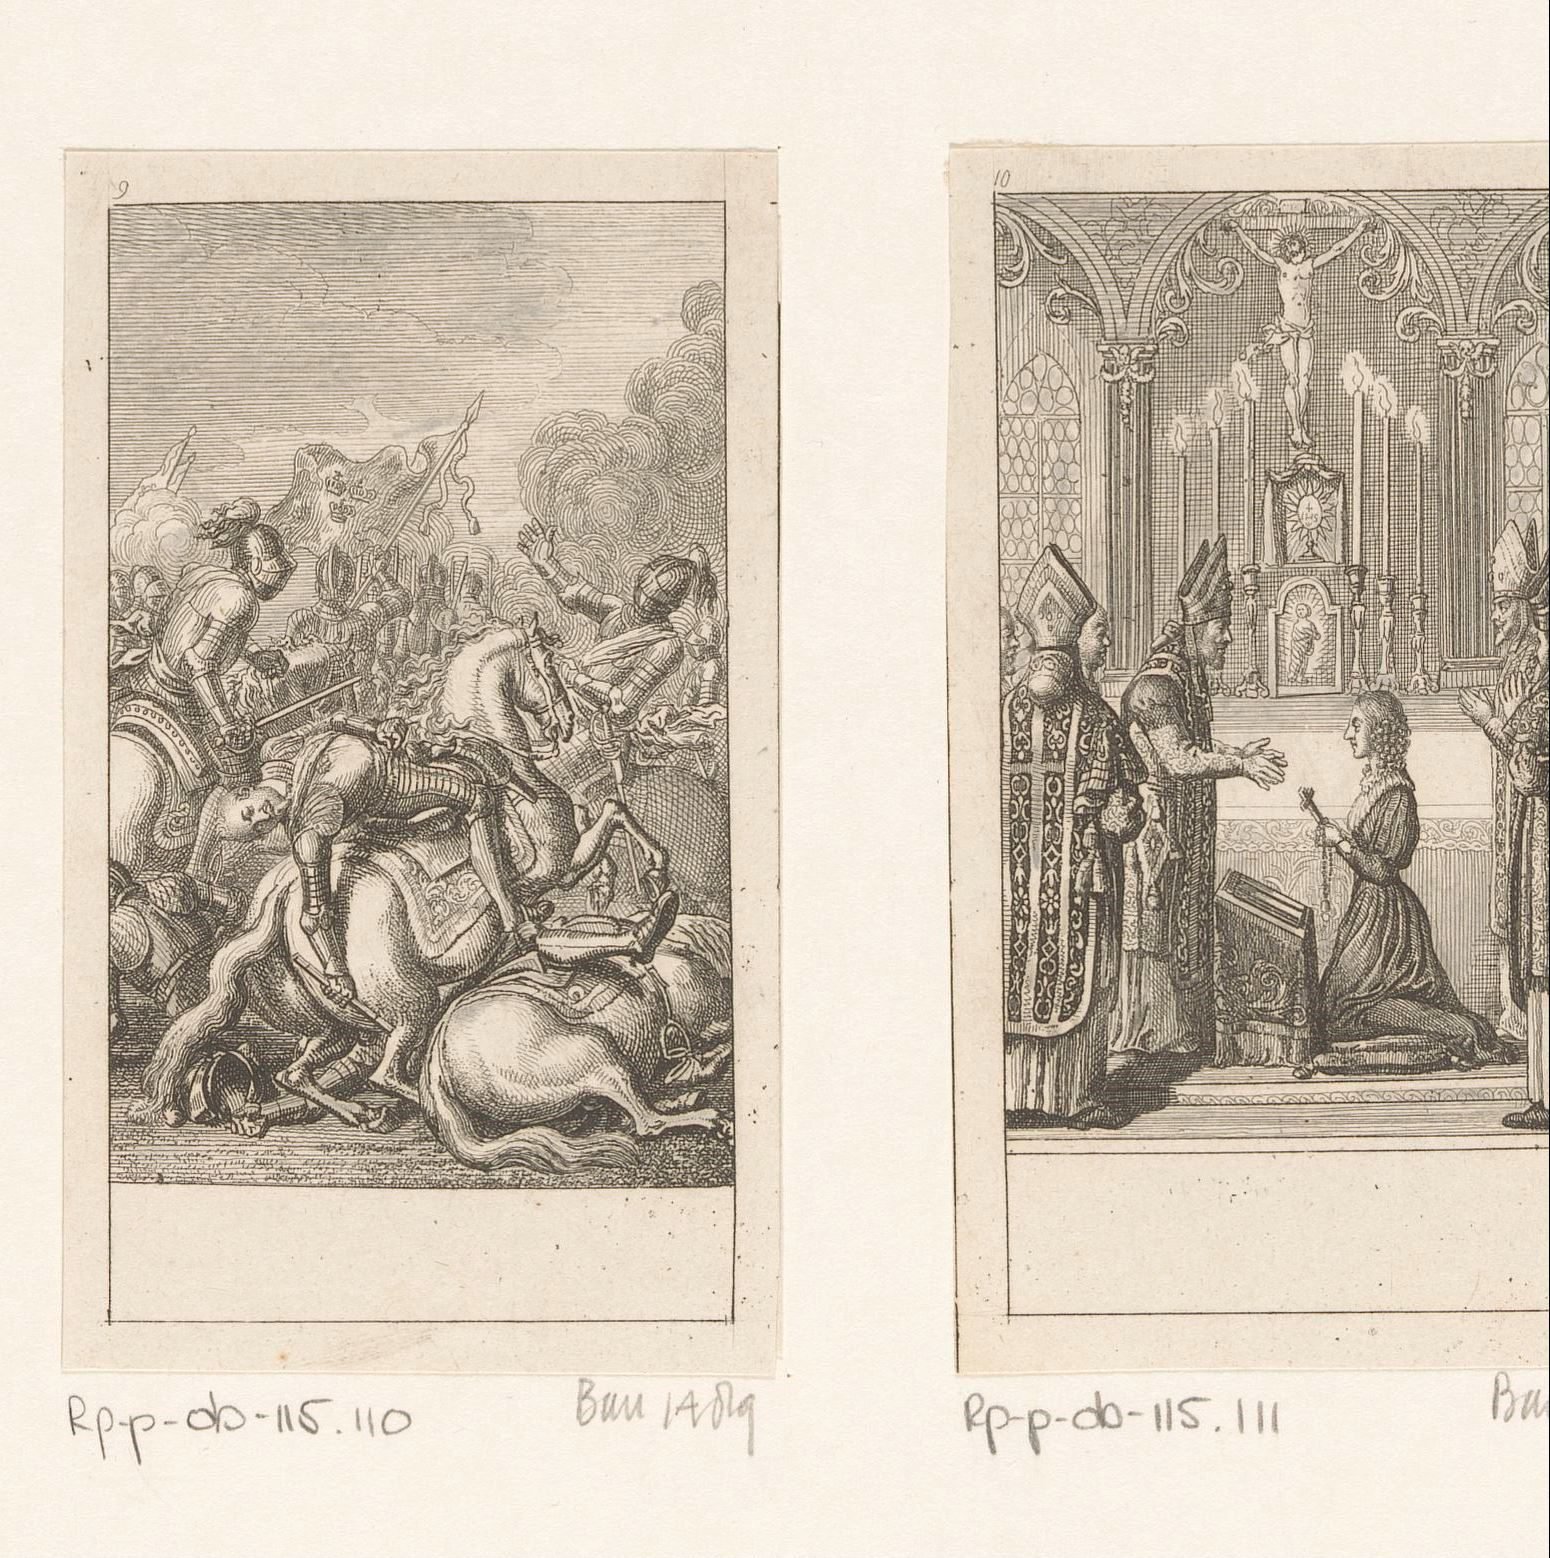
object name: print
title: Gustaaf Adolf II komt om in de slag bij Lützen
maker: daniel nikolaus chodowiecki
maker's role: draughtsman, print maker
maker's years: 1726-1801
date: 1790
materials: paper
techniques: etching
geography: berlin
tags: violent death, being killed; being mishandled and maltreated; seeking death (+ death during war), history, battle, ruler, sovereign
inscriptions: collector's mark: Lugt 2228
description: Latere staat gebruikt voor: Gothaischer Hof Kalender zum Nutzen und Vergnügen eingerichtet auf das Jahr 1791. Gotha: C. W. Ettinger, [1790].